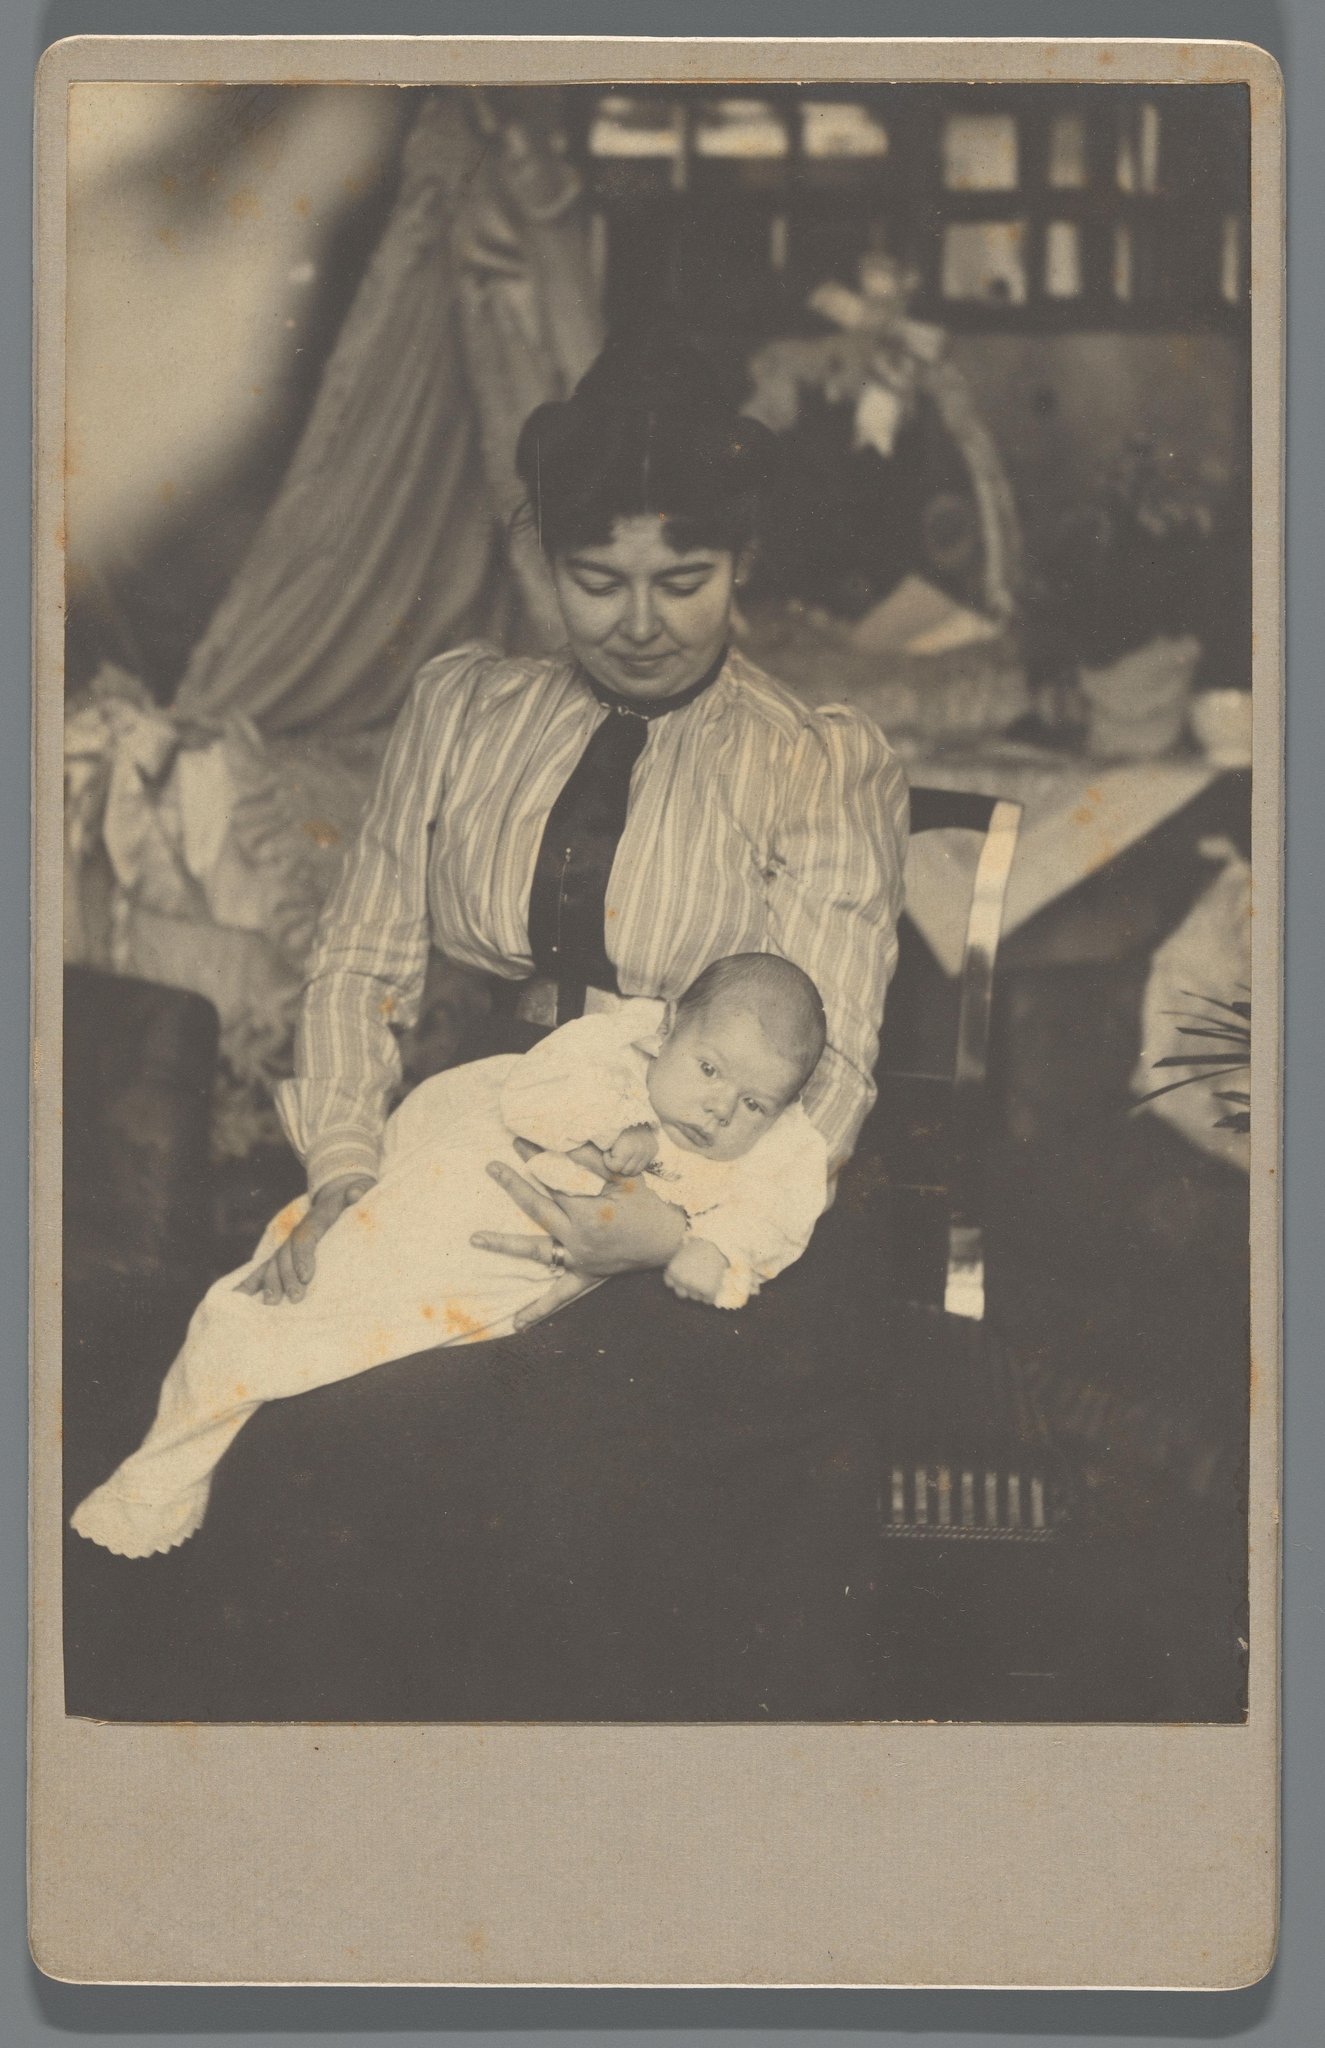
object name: cabinet photograph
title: Portret van A.C.M. Geertsema met een baby op schoot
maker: Anonymous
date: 1900-1920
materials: cardboard, photographic support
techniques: albumen print